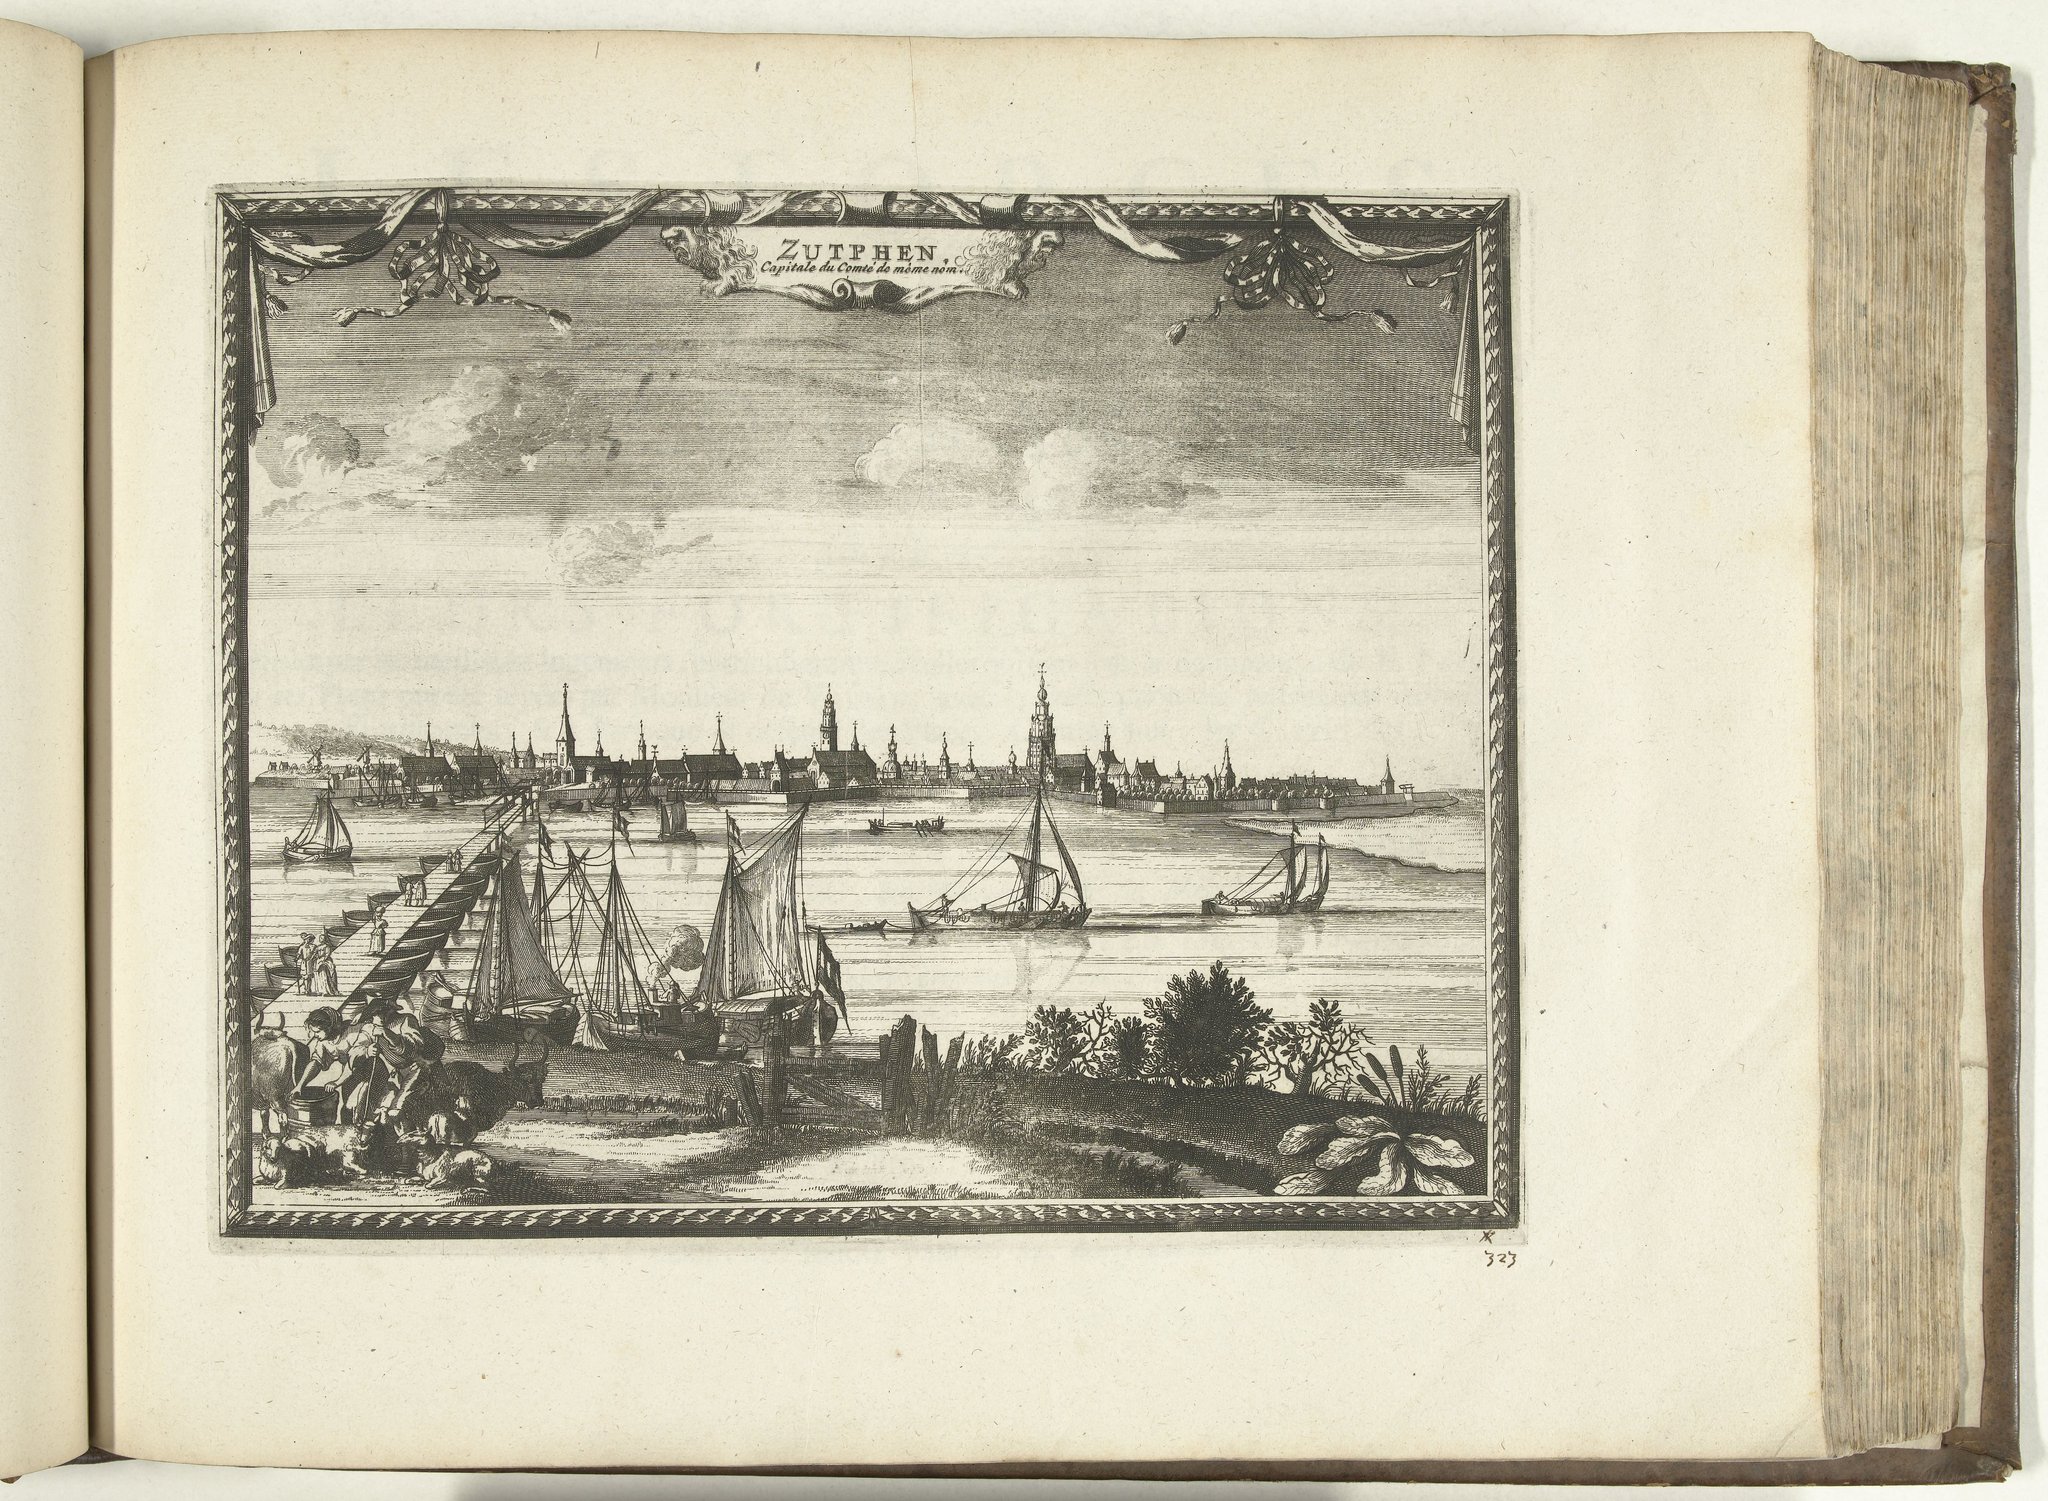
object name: print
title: Les Forces de l'Europe, Asie, Afrique et Amerique (...) Comme aussi les Cartes des Côtes de France et d'Espagne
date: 1726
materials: paper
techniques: etching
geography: northern netherlands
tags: zutphen (stad), spaanse successieoorlog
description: Gezicht op Zutphen, op de voorgrond een schipbrug. Plaat nr. 323 in deel XIII van het prentwerk: Les Forces de l'Europe, Asie, Afrique et Amerique ... Comme aussi les Cartes des Côtes de France et d'Espagne uit 1726, dit tweede deel met 271 met de hand genummerde platen van vermaarde sterke steden en vestingen in het kader van de Spaanse Successieoorlog 1701-1713. Voor het merendeel zijn deze platen gekopieerd naar de anonieme Franse platen van vermaarde sterke steden en vestingen: in Les forces de l'Europe en in: Le theatre de la guerre, dans les Pays-Bas, beide oorspronkelijk uitgegeven door Nicolas de Fer te Parijs (1693-1697) in het kader van de Negenjarige Oorlog. Titel in het Frans. Rechtsonder is de letter r met pen doorgekrast.